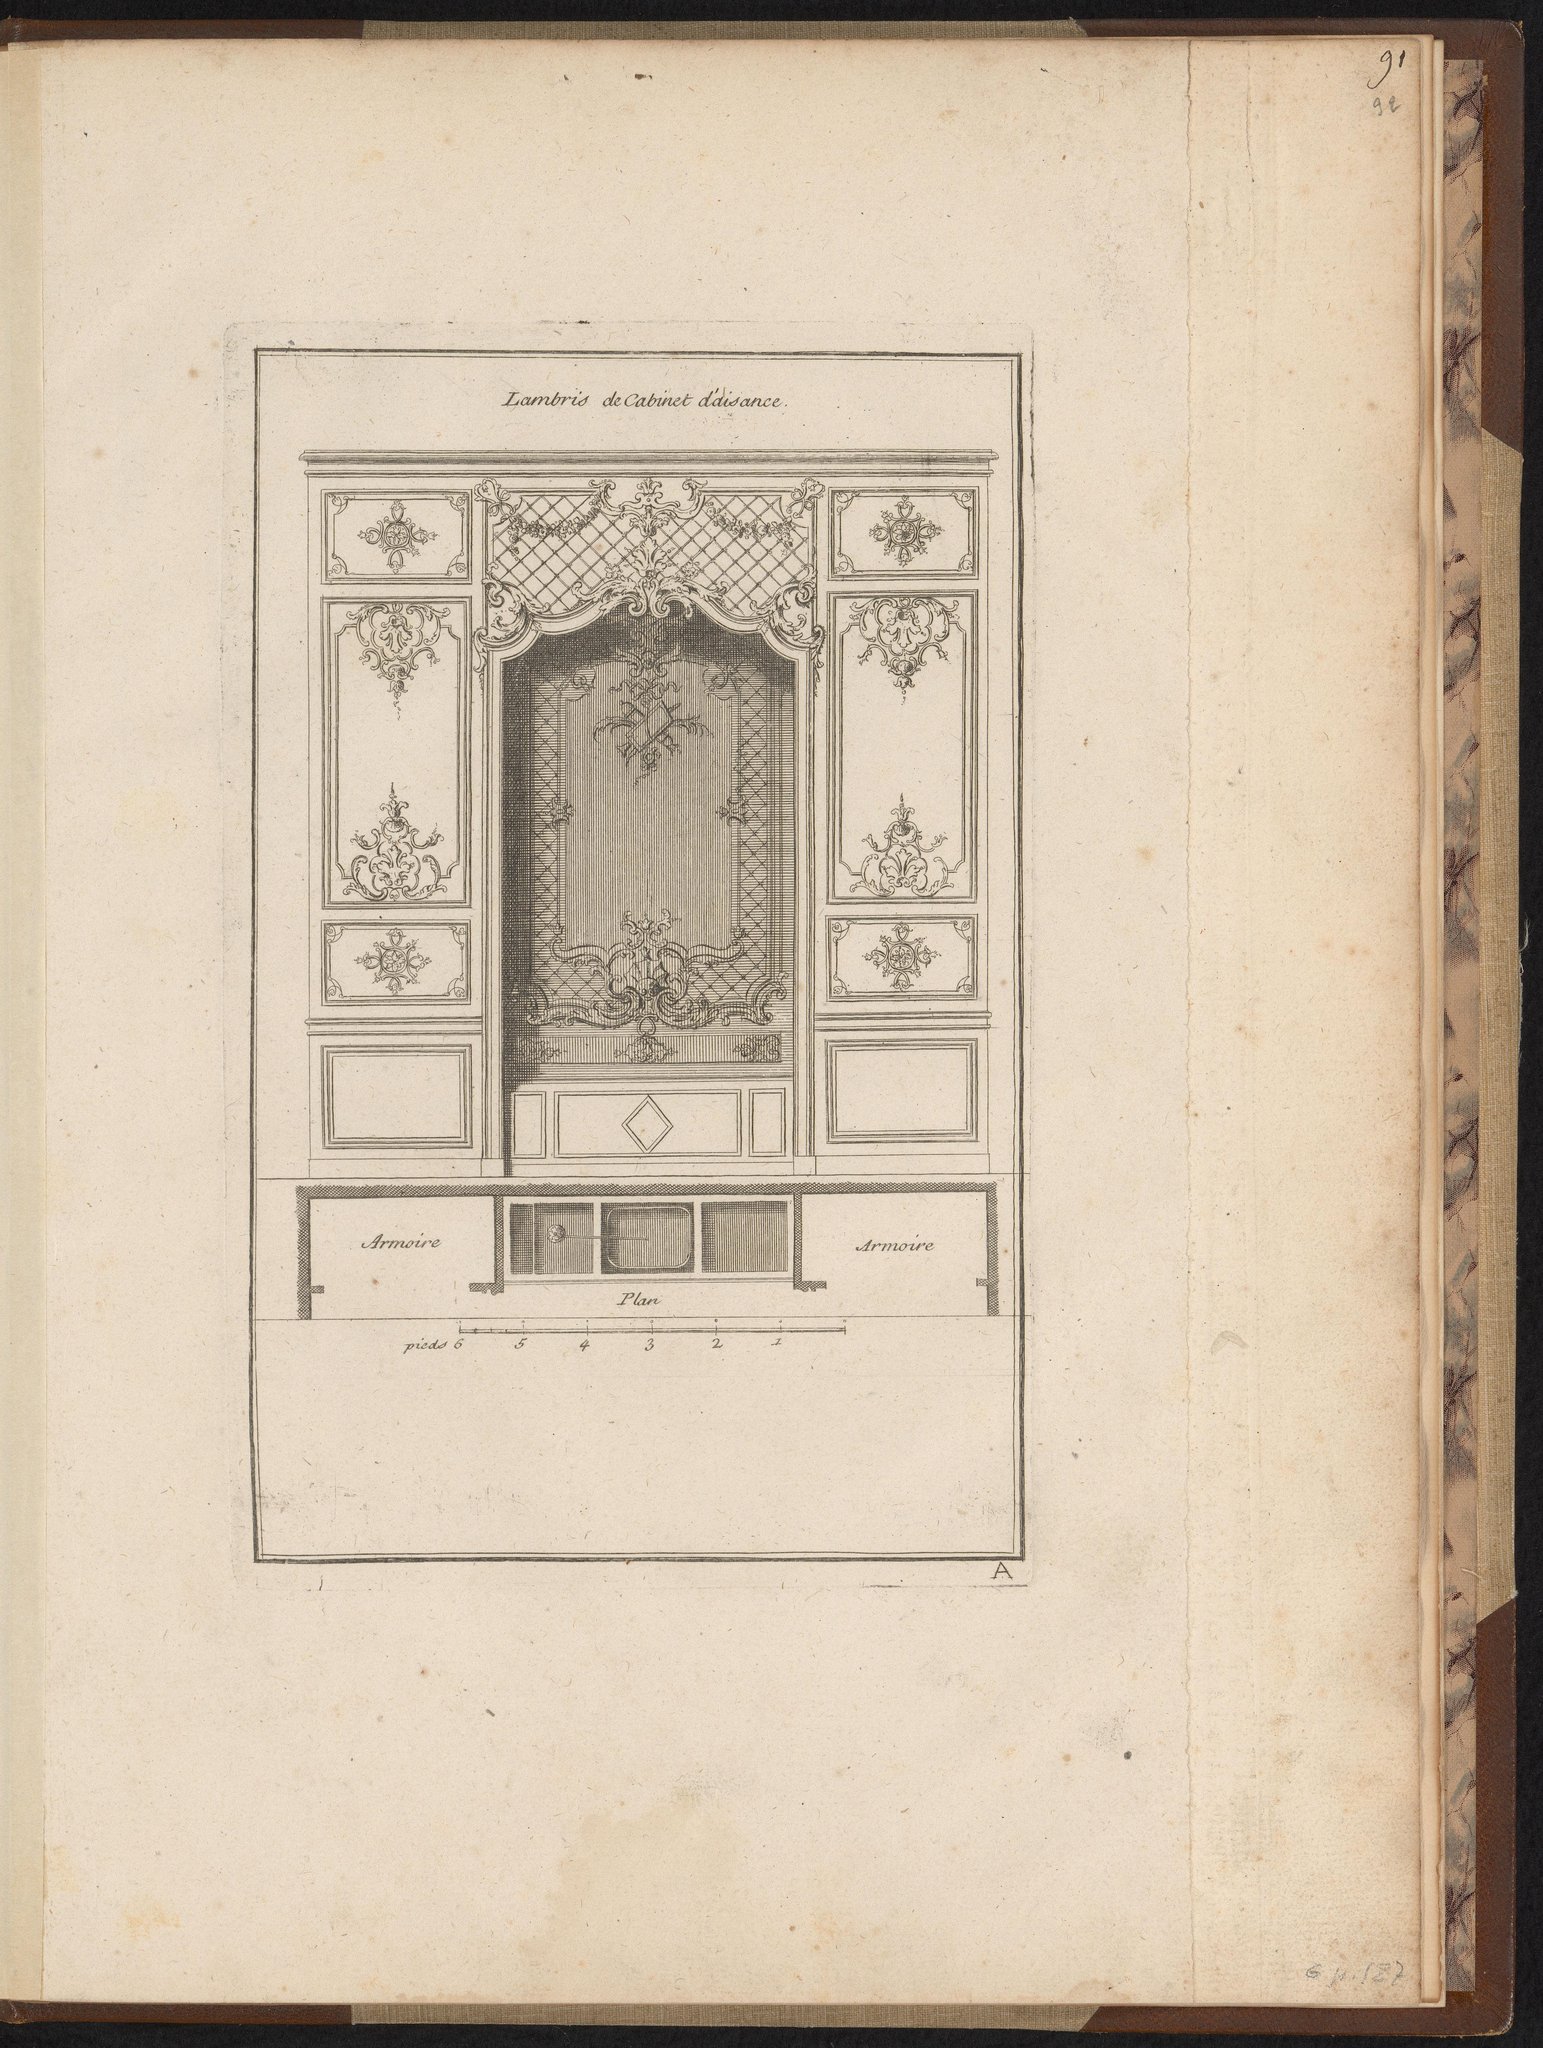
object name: album leaf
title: Ontwerp voor een in de muur verzonken wasgelegenheid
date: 1725-1750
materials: paper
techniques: etching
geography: paris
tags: ornaments ~ art, panelling, washing and bathing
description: Deze prent maakt deel uit van een album.